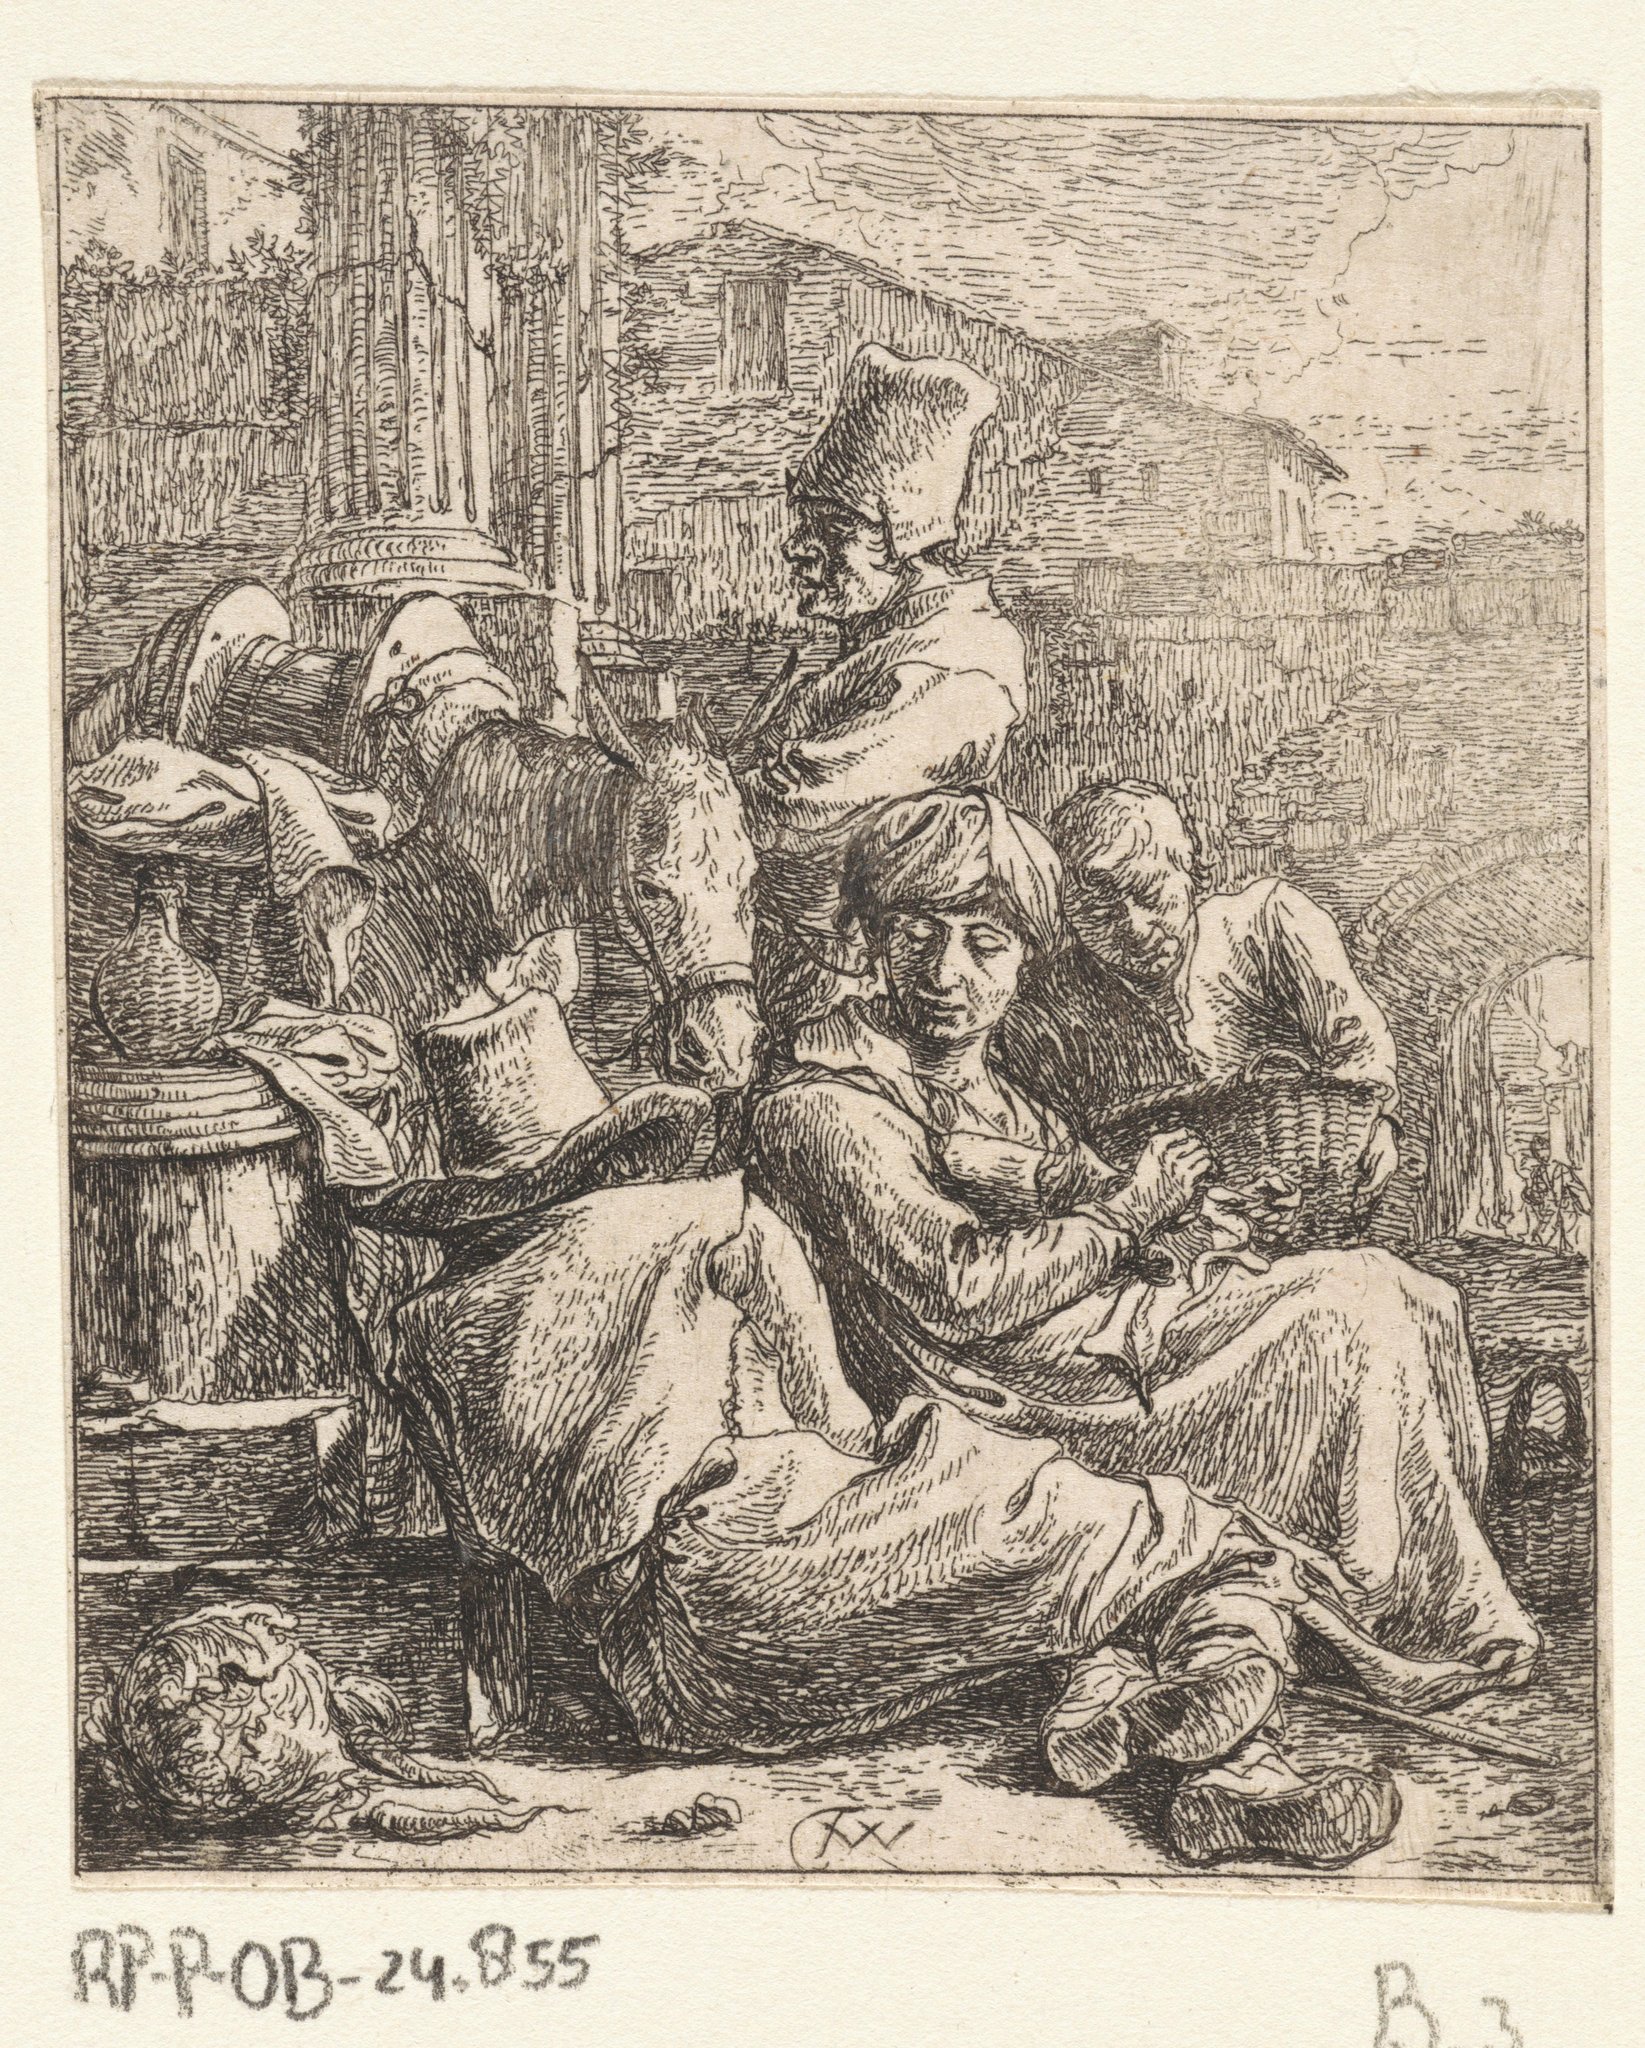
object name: print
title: Naaister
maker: thomas wijck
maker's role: draughtsman, painter, print maker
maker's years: 1616-1677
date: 1626-1677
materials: paper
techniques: etching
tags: ass, donkey, sewing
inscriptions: collector's mark: Lugt 240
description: Een vrouw is aan het naaien. Ze wordt omringd door drie mannen en een ezel. Rechts op de achtergrond een stadspoort.